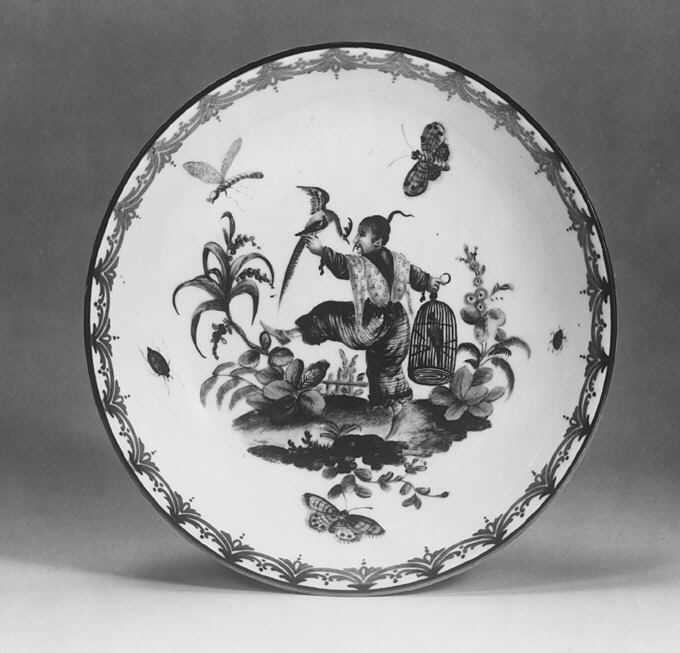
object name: cup and saucer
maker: frankenthal porcelain manufactory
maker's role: manufactory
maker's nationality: german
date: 1775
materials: hard paste porcelain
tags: birds,men,insects